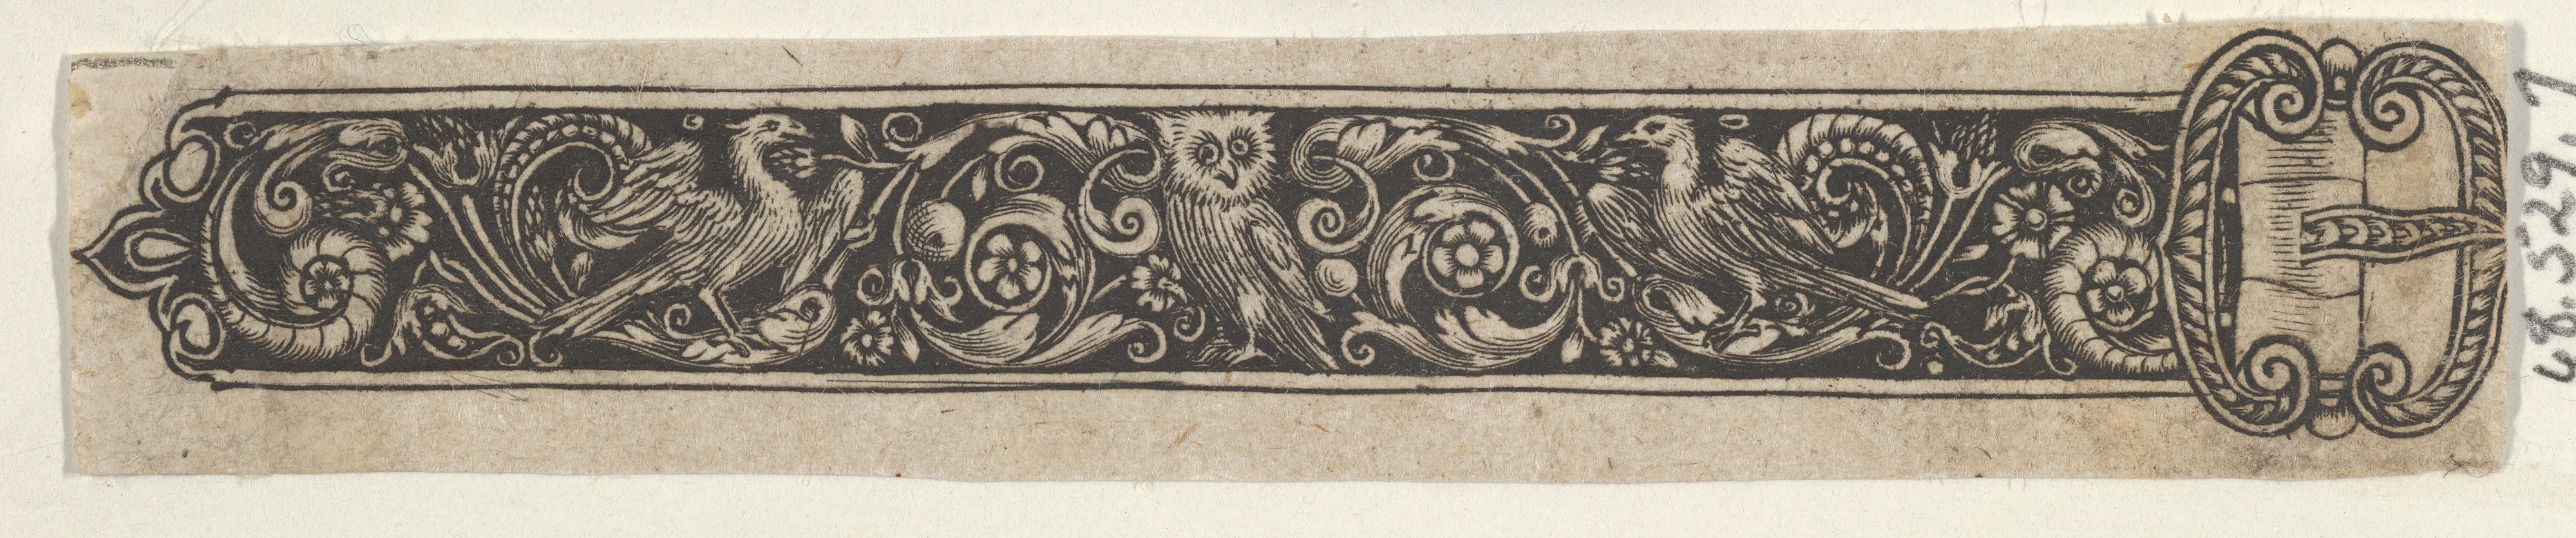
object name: print ornament architecture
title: Reverse Copy of a Design for a Buckle with an Owl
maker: theodor de bry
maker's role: artist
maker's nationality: netherlandish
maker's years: 1528-1598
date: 1580-1600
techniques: embroidery, engraving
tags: birds,owls